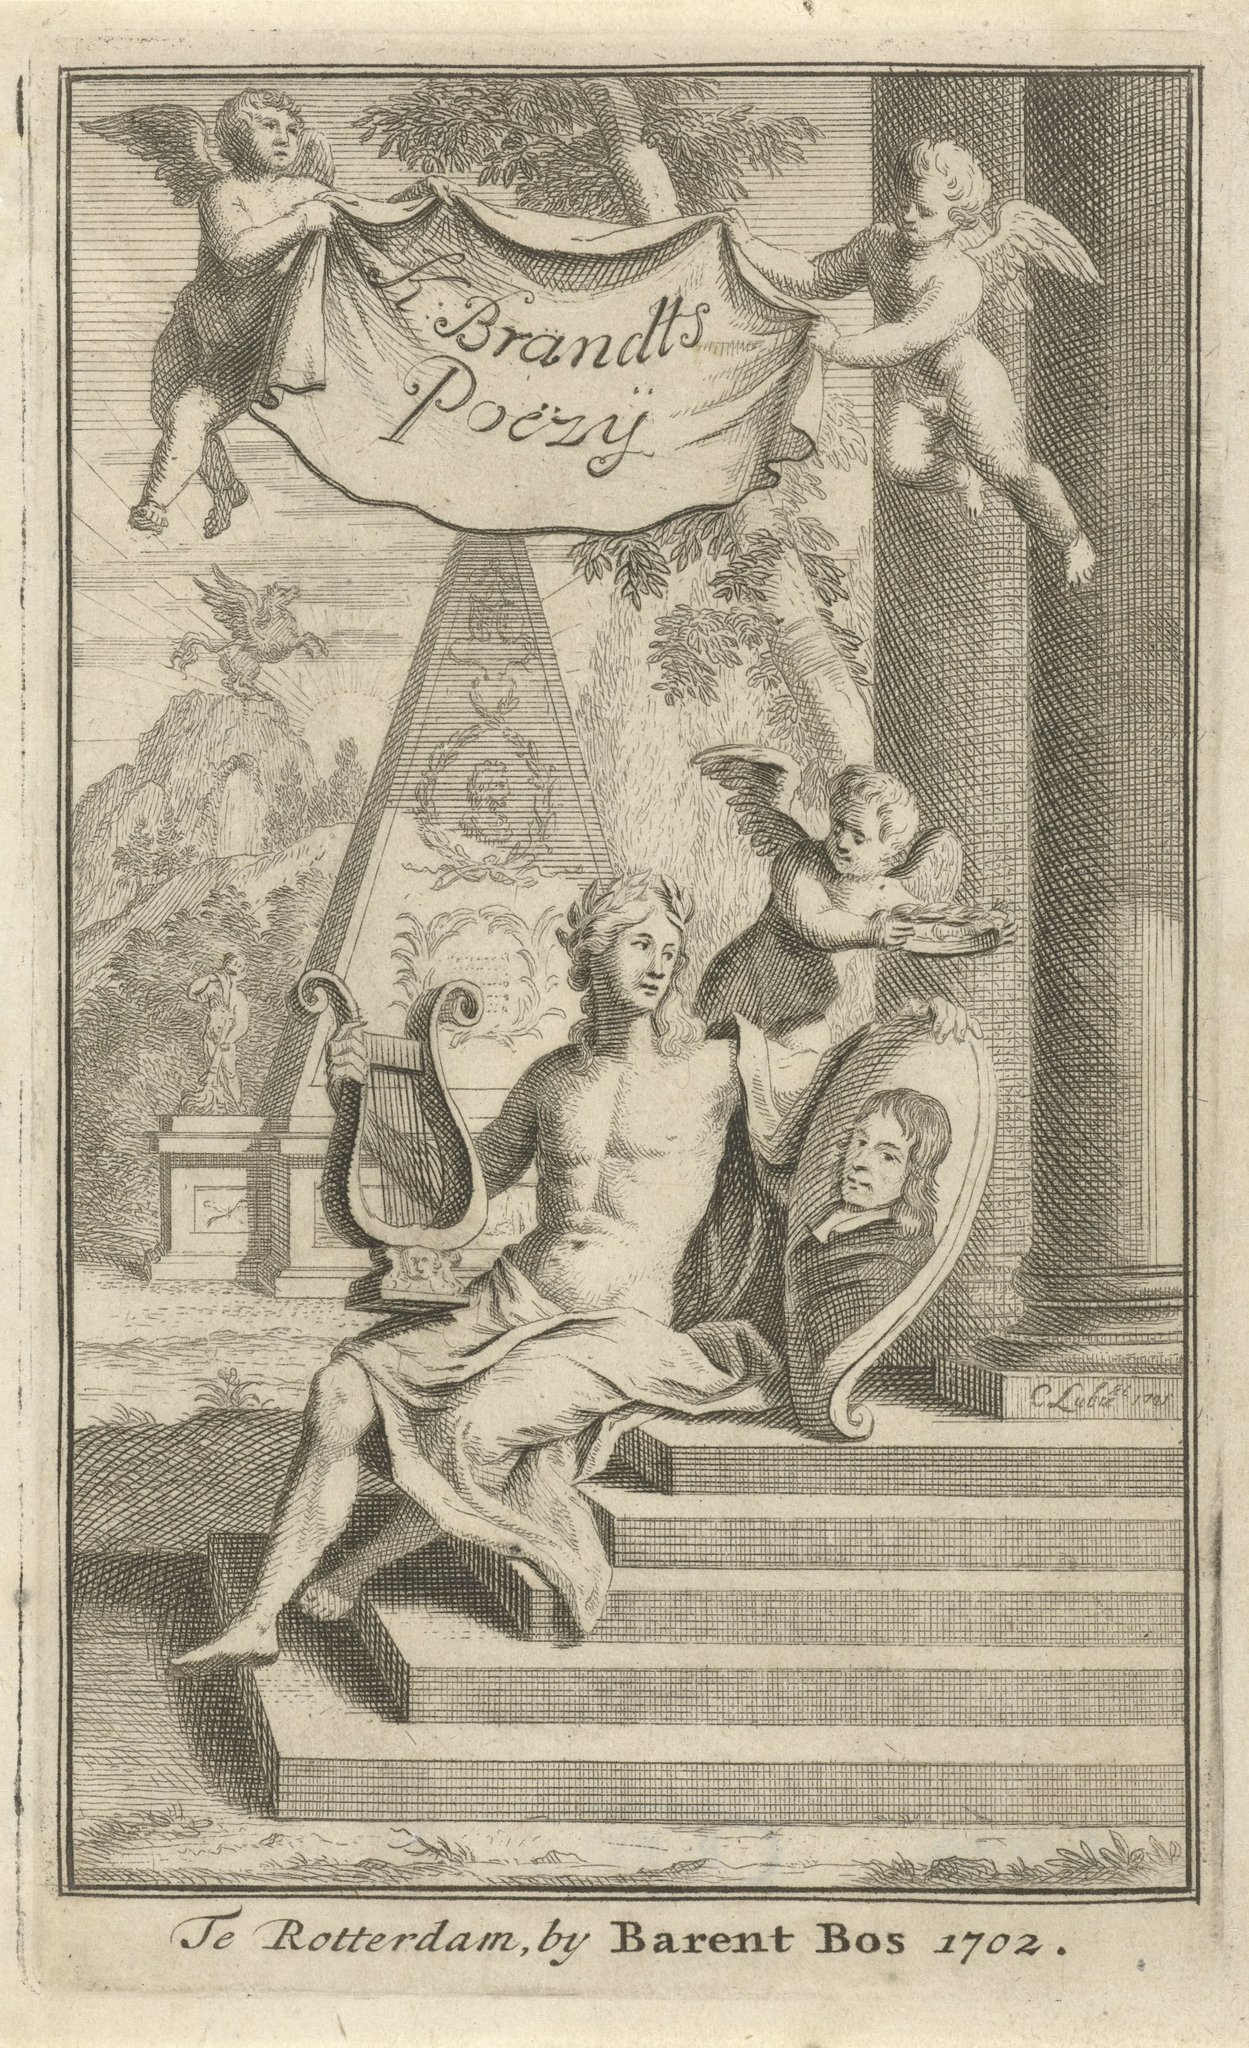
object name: titelblad, titelpagina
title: Apollo met portret van Caspar Brandt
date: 1702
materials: paper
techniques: etching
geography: rotterdam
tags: pegasus, the winged horse, (story of) apollo (phoebus), portrait of a writer, grave, tomb and other grave-forms and grave-markers, cupids: 'amores', 'amoretti', 'putti', crowning the victor with laurel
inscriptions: collector's mark: Lugt 2228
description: Apollo zit met zijn lier op een bordes en houdt een schild met het auteursportret van Caspar Brandt vast. Een putto vliegt met een lauwerkrans boven het portret. Op de achtergrond een gedenkteken voor de overleden schrijver en het gevleugelde paard Pegasus. In de lucht houden twee putti een doek met de titel van het boek vast.